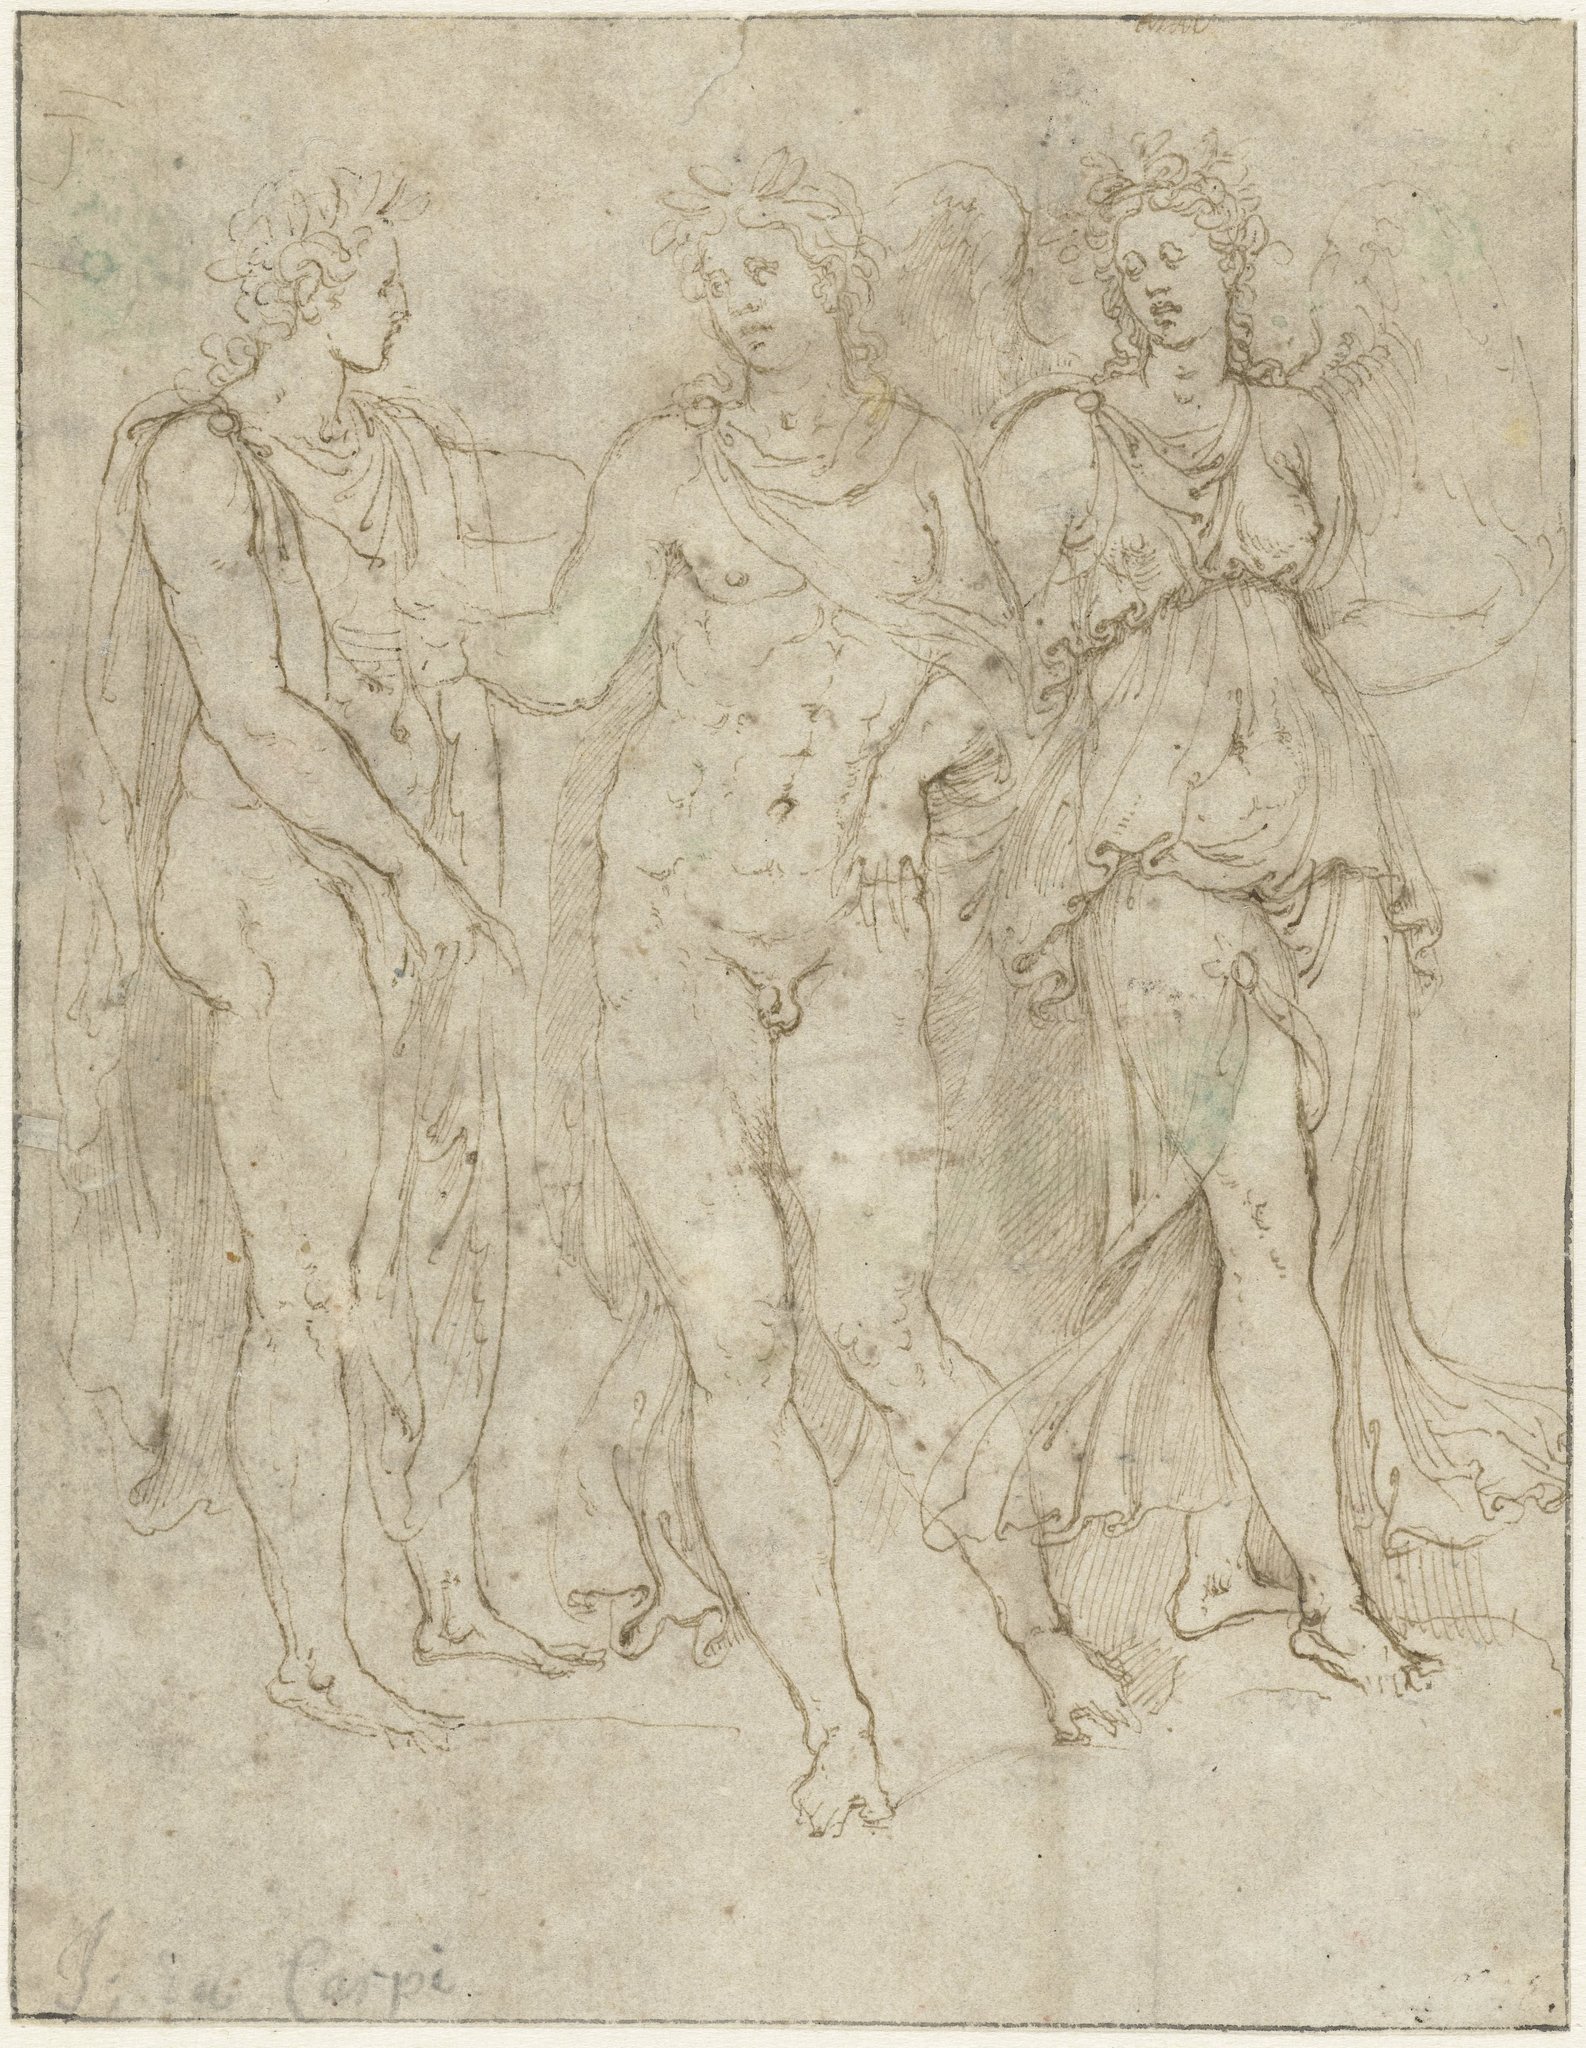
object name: drawing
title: Victoria leidt een gelauwerde man weg van een vriend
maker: girolamo da carpi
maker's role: draughtsman, painter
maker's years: 1501-1556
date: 1549-1553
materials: ink, paper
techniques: pen